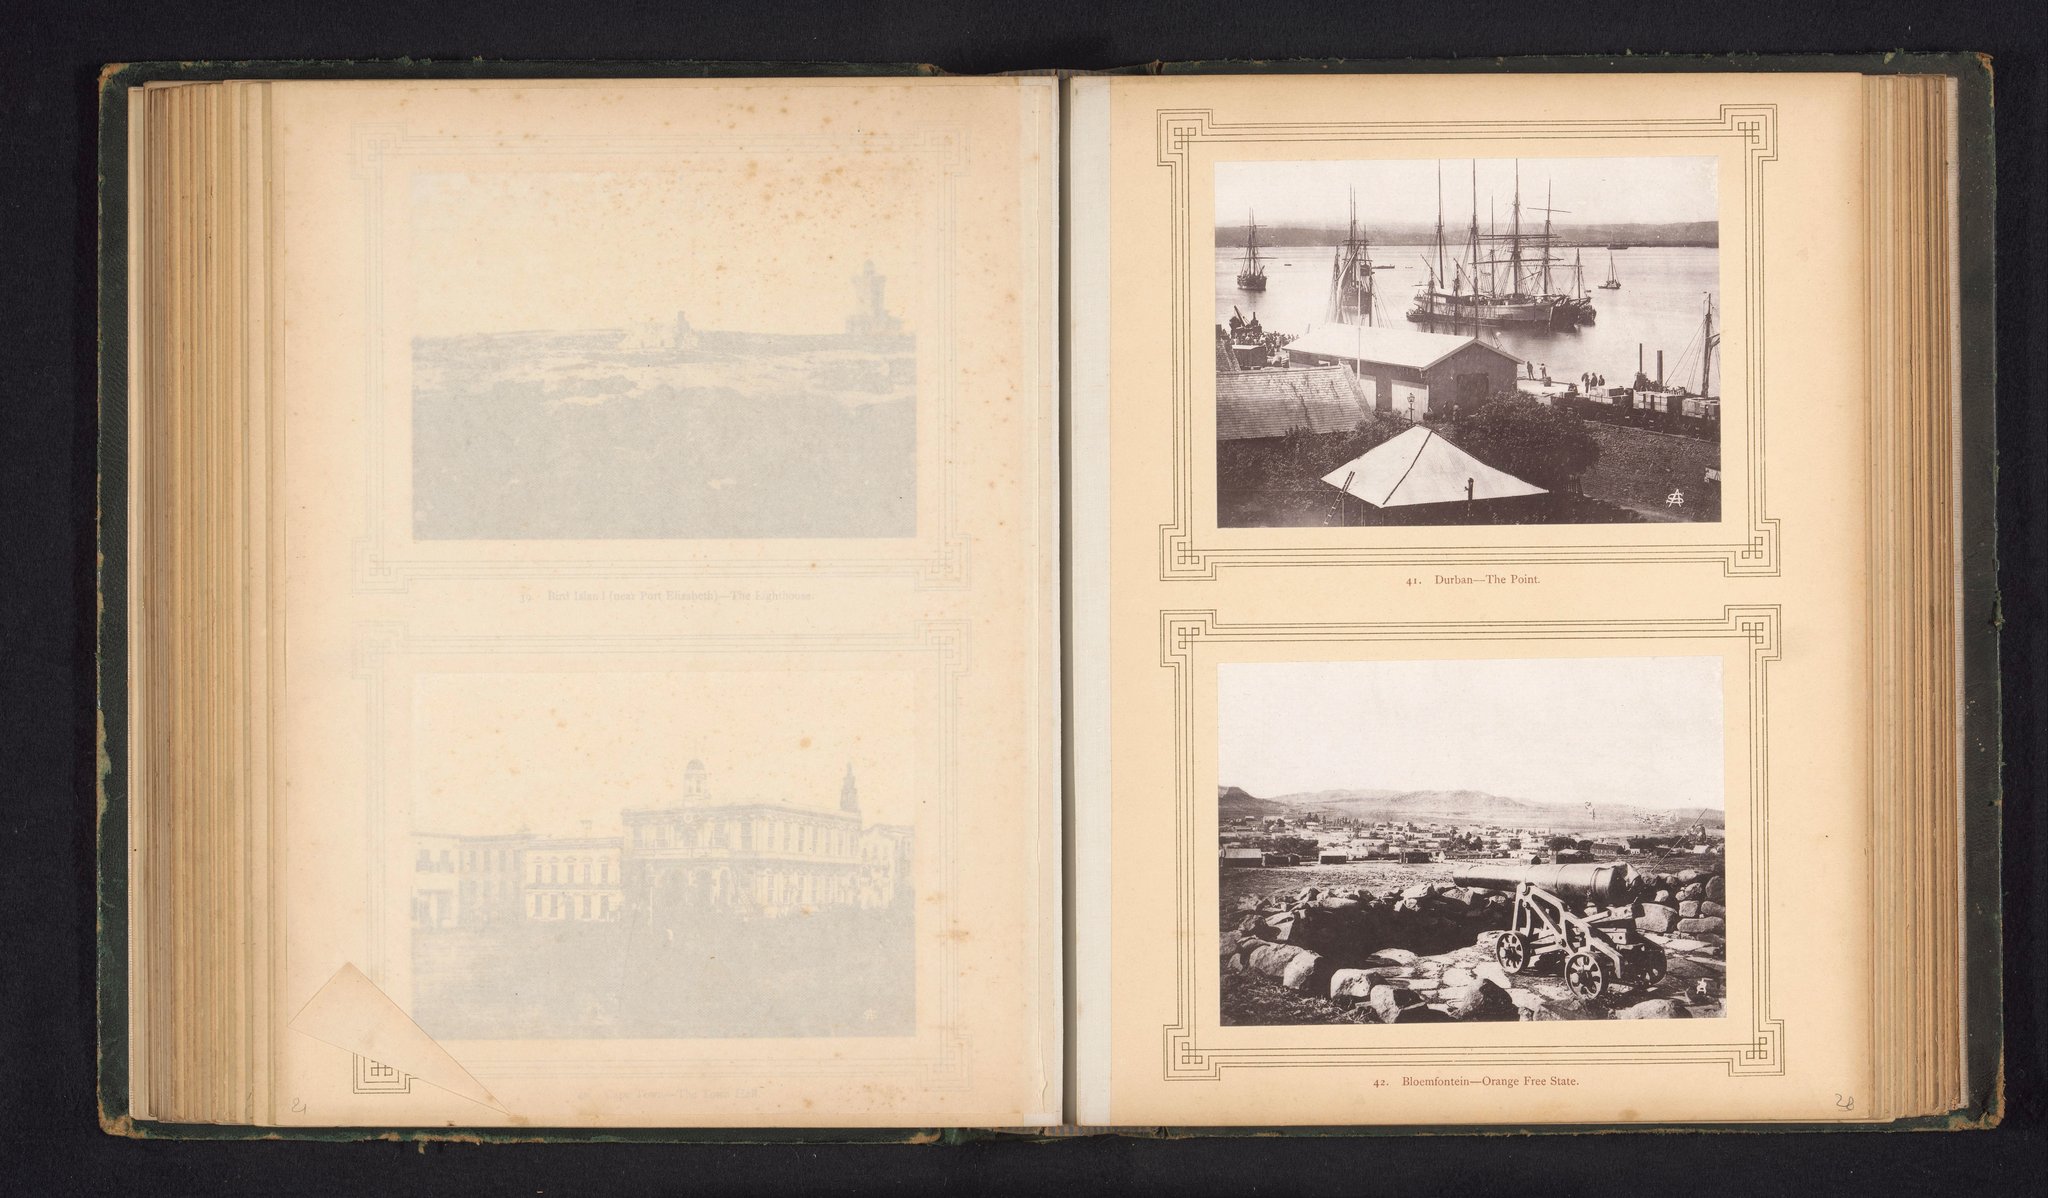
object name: page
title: Bloemfontein-Orange Free State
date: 1870-1880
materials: paper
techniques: photograph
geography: south africa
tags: city-view in general; 'veduta', ships (in general), firearms: cannon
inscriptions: number: ‘41. 42.’, inscription: ‘SA’